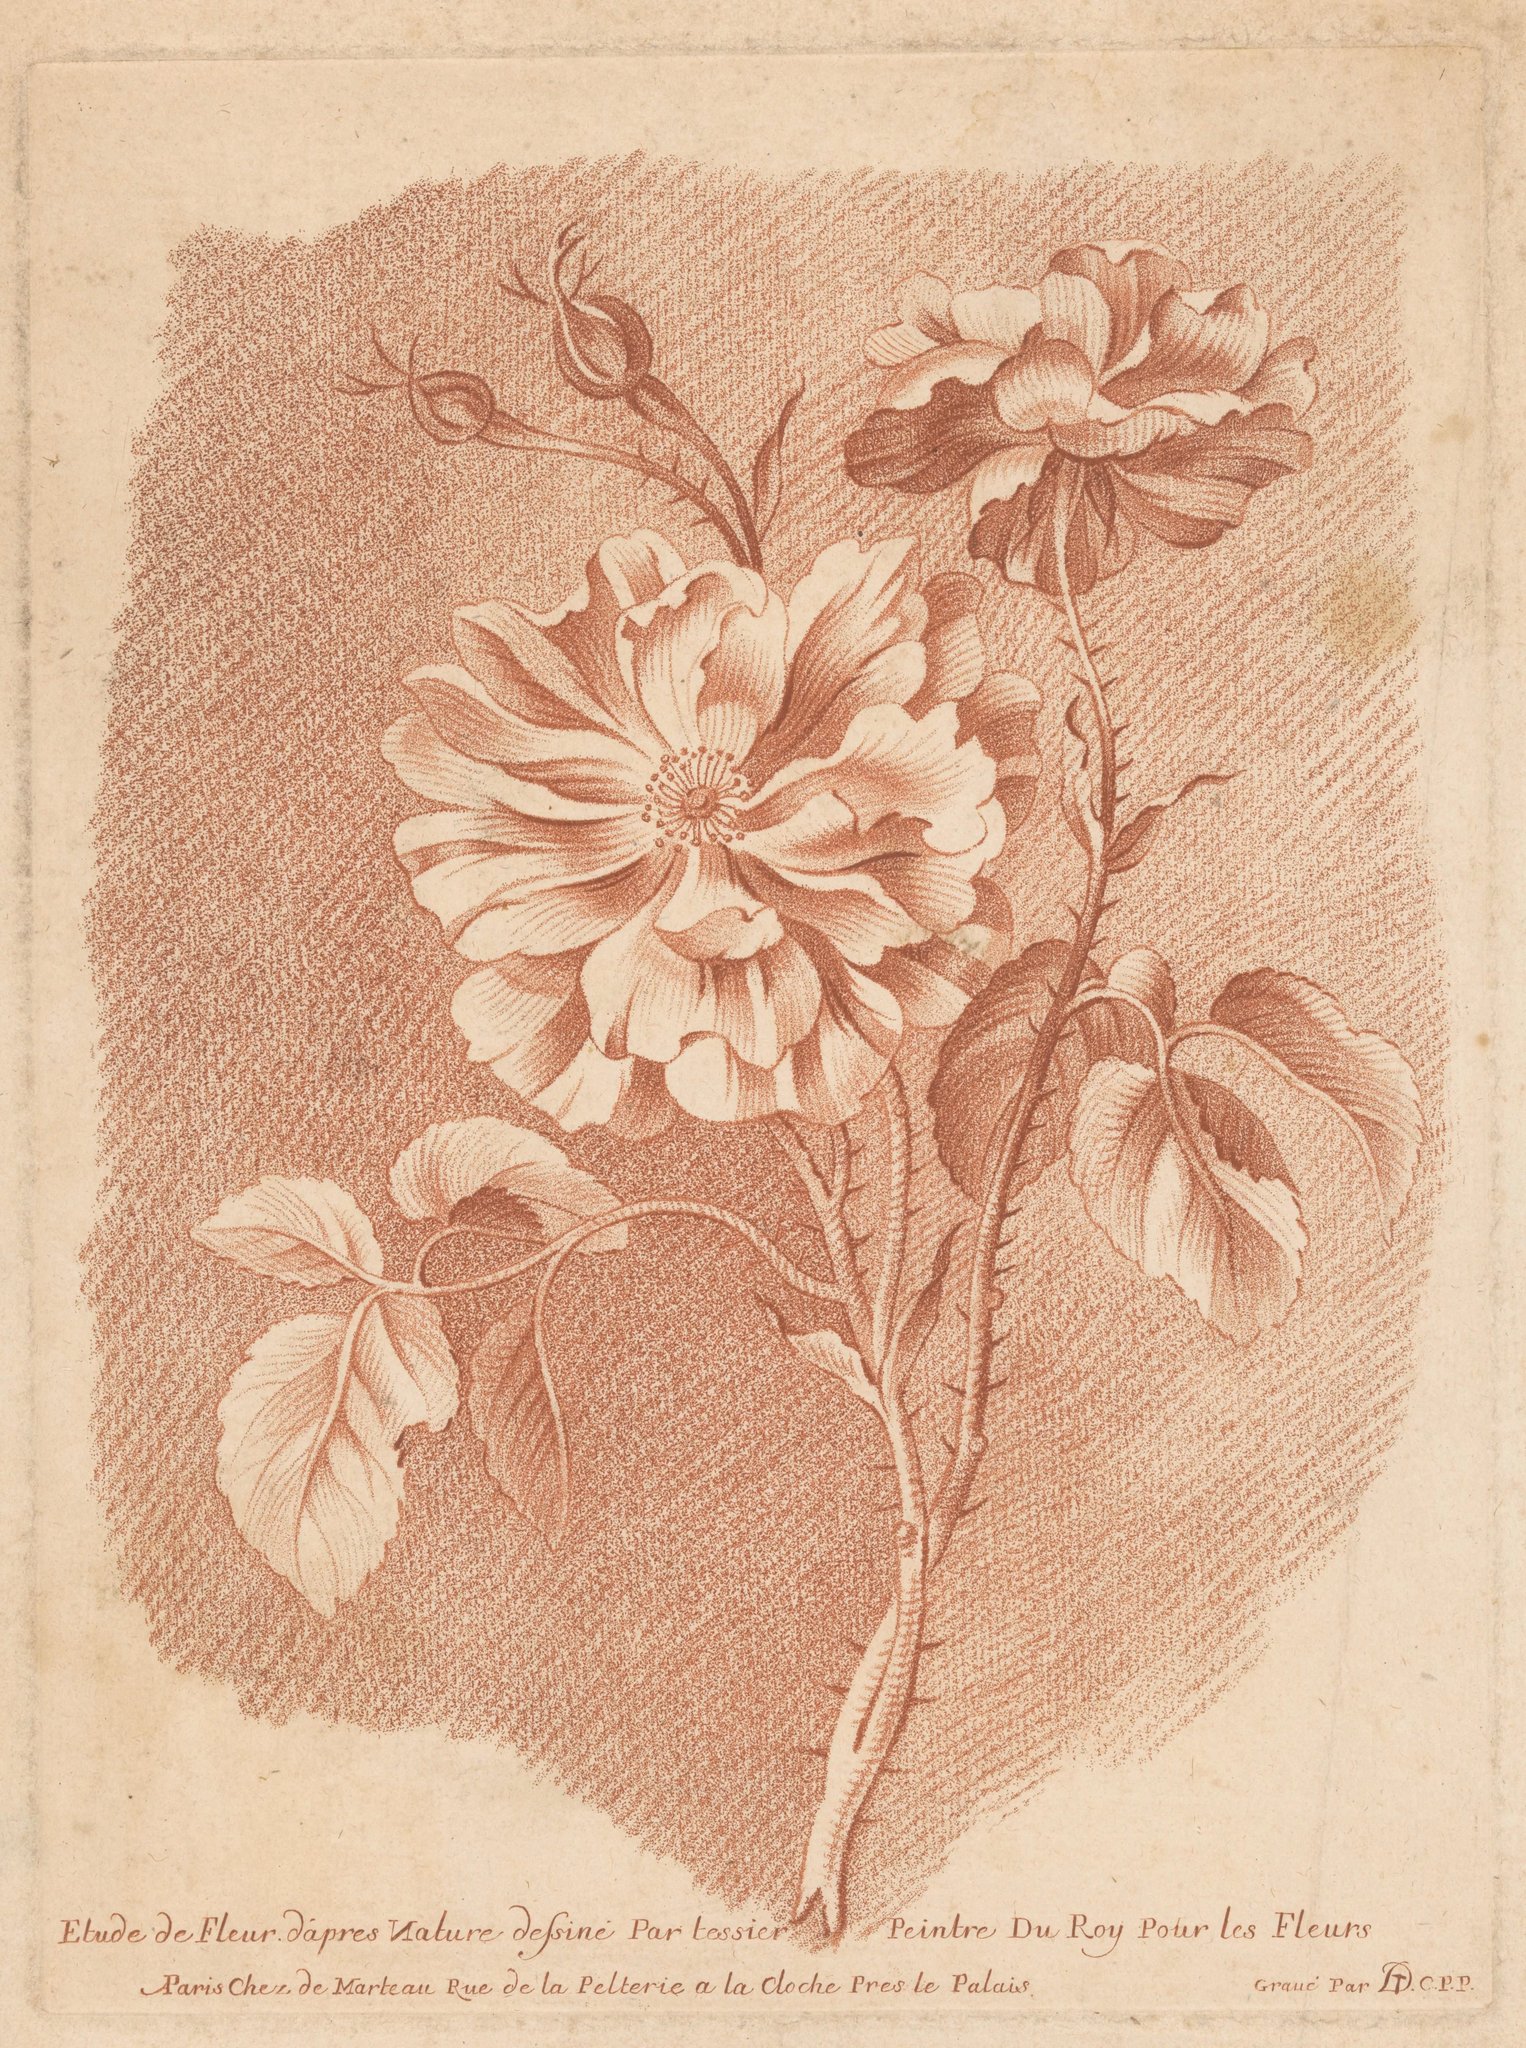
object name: print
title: Bloemen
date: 1755-1776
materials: paper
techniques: printmaking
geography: paris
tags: flowers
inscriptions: collector's mark: Lugt 2228